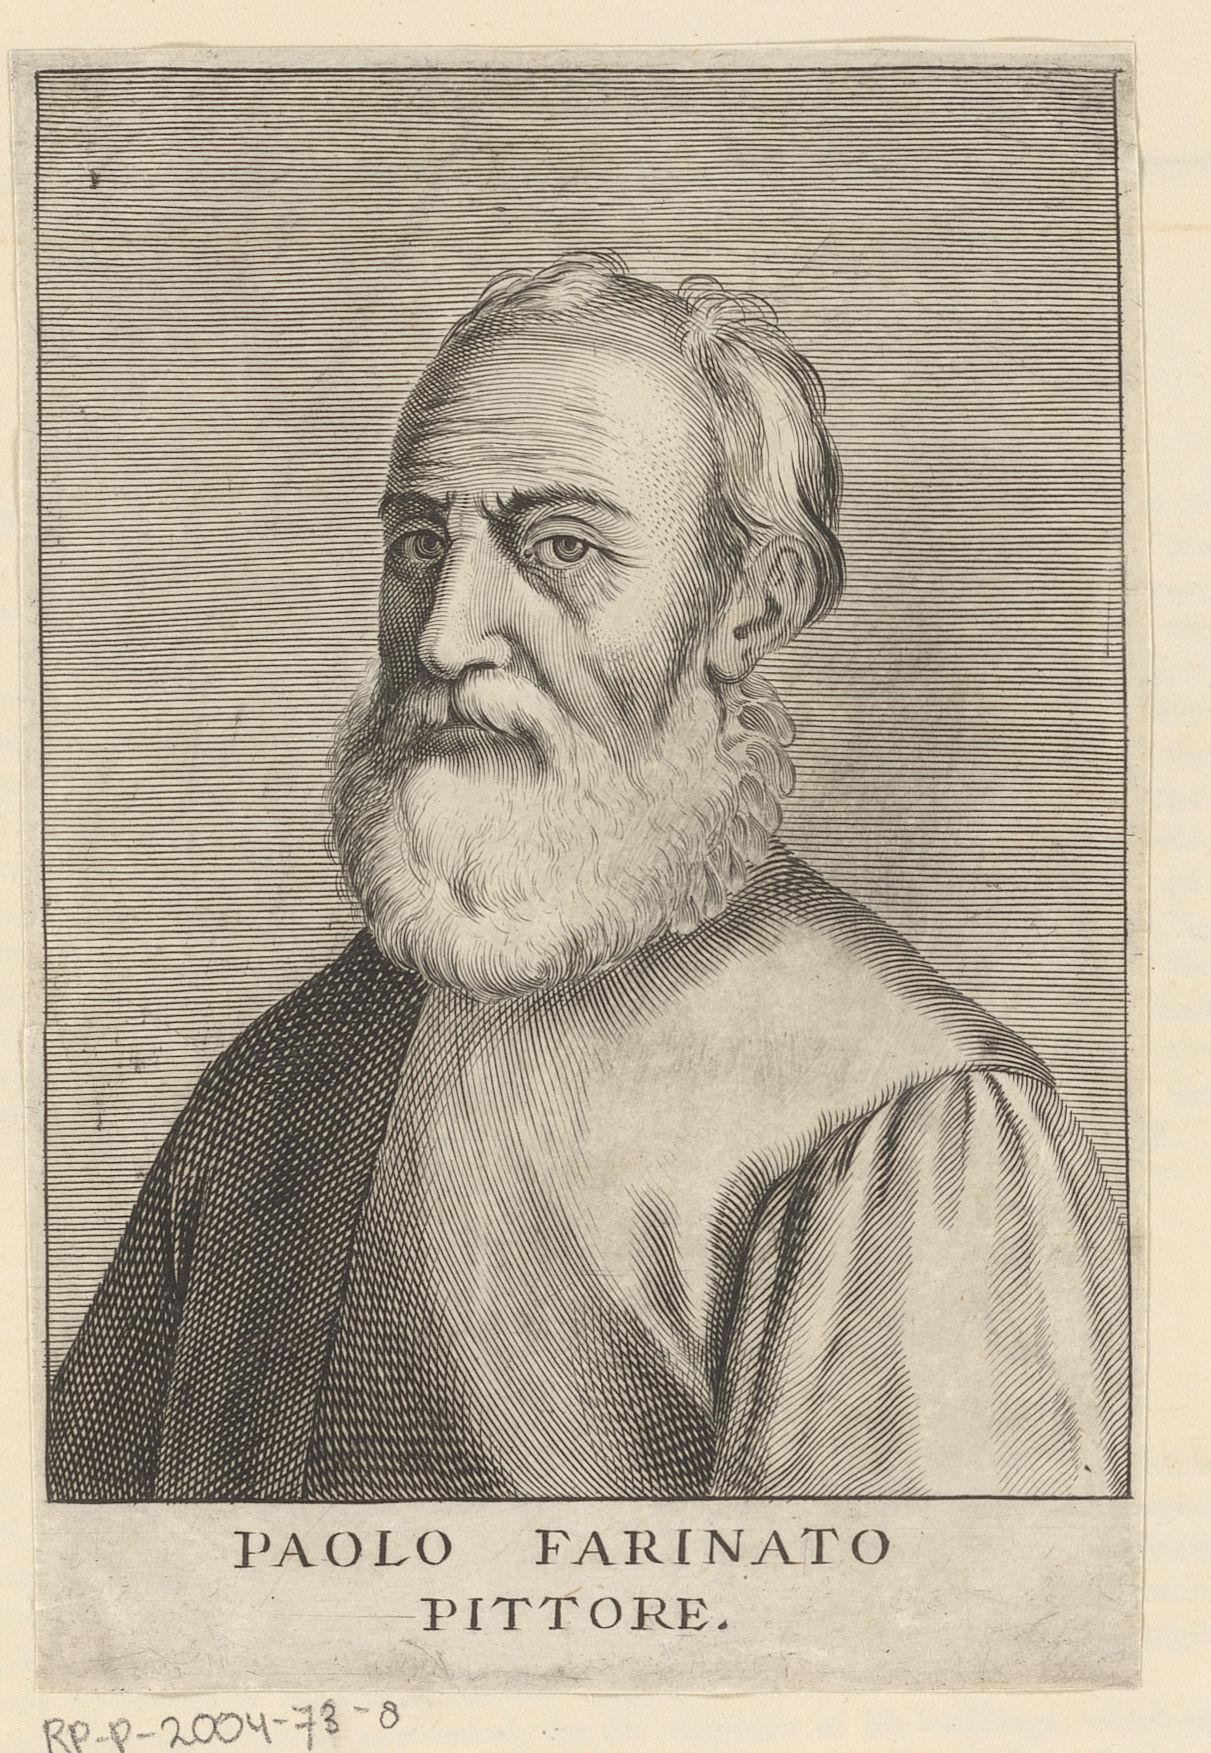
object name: print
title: Portret van Paolo Farinati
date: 1648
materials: paper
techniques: engraving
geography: venice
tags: painter, paolo farinati, historical persons, portrait, self-portrait of painter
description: Prent uit: Ridolfi, Carlo. Le Maraviglie dell'arte, overo Le vite de gl'illustri pittori veneti, e dello stato. Ove sono raccolte le opere insigni, i costumi, & i ritrati loro, con la narratione delle historie, delle favole, e delle moralità da quelli dipinte. Venetië: s.n., 1648, p. 124. De samensteller heeft deze prent in het album geplakt als illustratie bij: Pilkington, Matthew en Johann Heinrich Füssli. A dictionary of painters, from the revival of the art to the present period. 4 dln. Londen: John Crowder, 1805, dl. 2, p. 183.